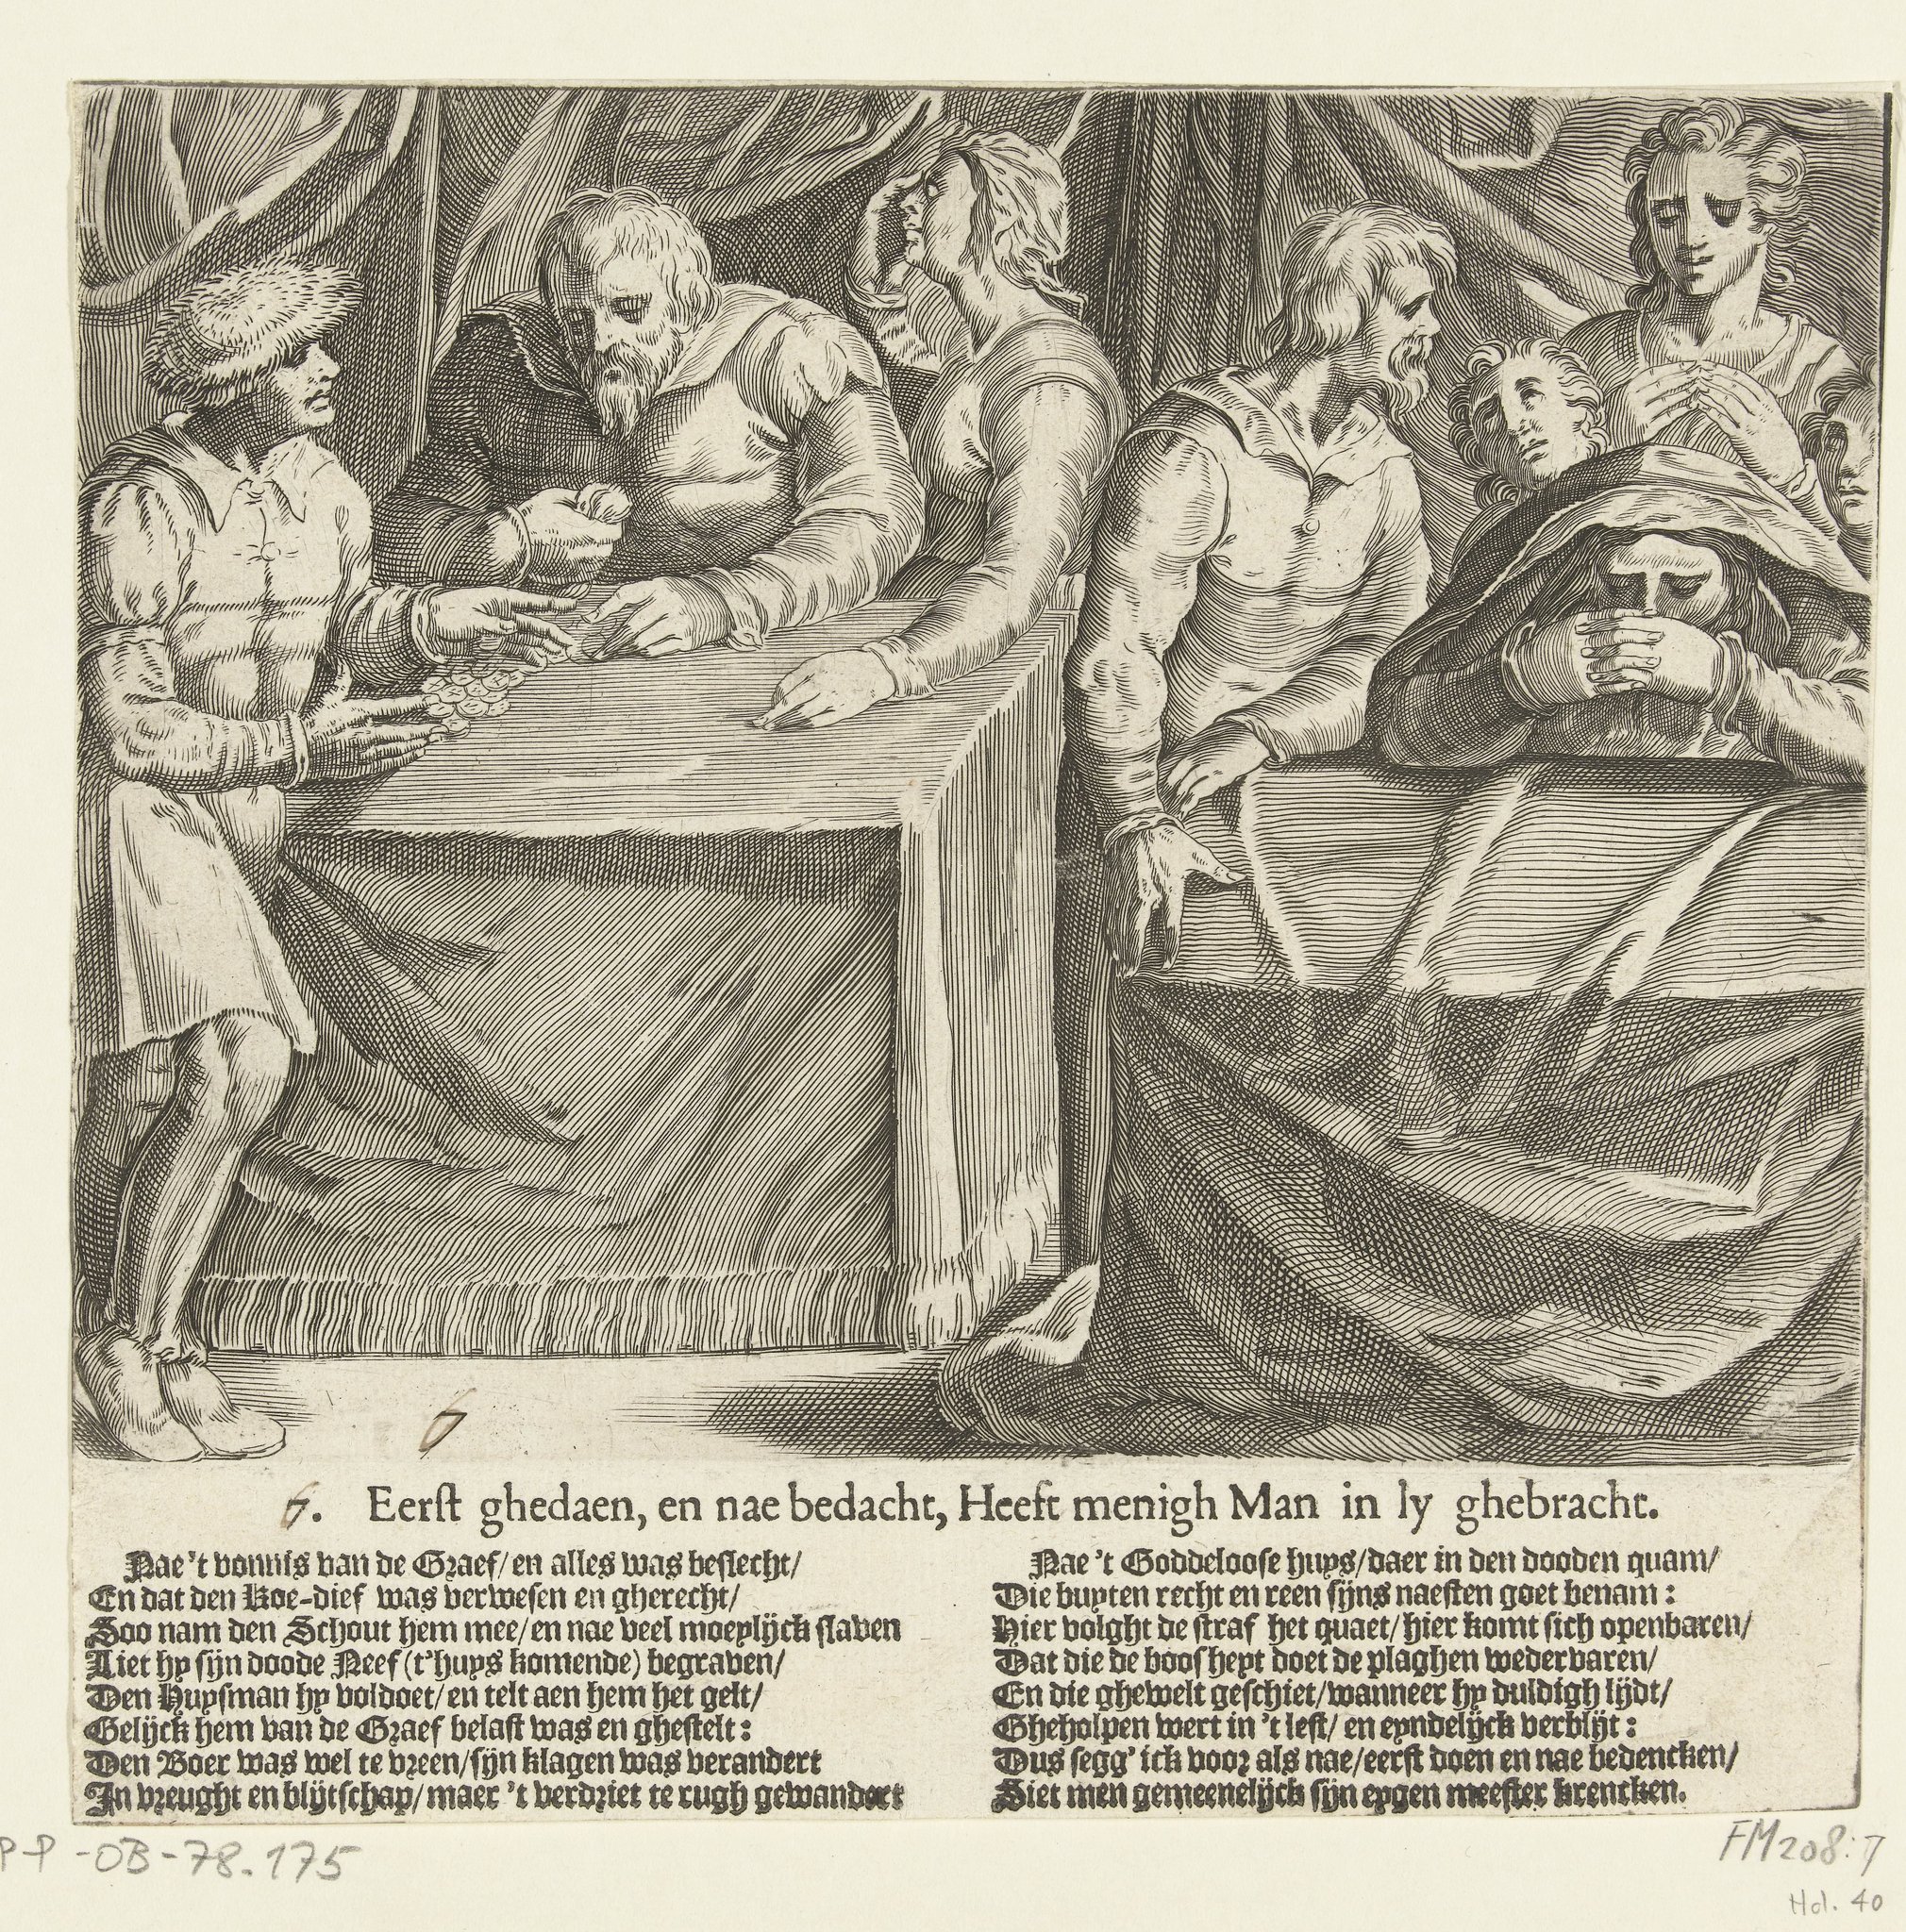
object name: history print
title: 7. Eerst ghedaen, en nae bedacht, Heeft menigh Man in ly ghebracht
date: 1613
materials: paper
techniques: engraving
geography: northern netherlands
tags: willem iii de goede (graaf van holland en henegouwen), netherlands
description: De schout van Dordrecht betaalt de boer zijn vergoeding van 100 goudstukken. Rechts treurt de weduwe van de baljuw van Zuid-Holland over de doodskist van haar terechtgestelde man. Voorstelling nr. 7 in een serie van zes kleine scènes van de opeenvolgende episoden van het verhaal van de Rechtspraak van graaf Willem III in het jaar 1336. Deze kleine prenten behoren aan weerszijden van de grote centrale voorstelling. Bij elke voorstelling een onderschrift bestaande uit een spreuk en een vers van twee kolommen van acht regels.